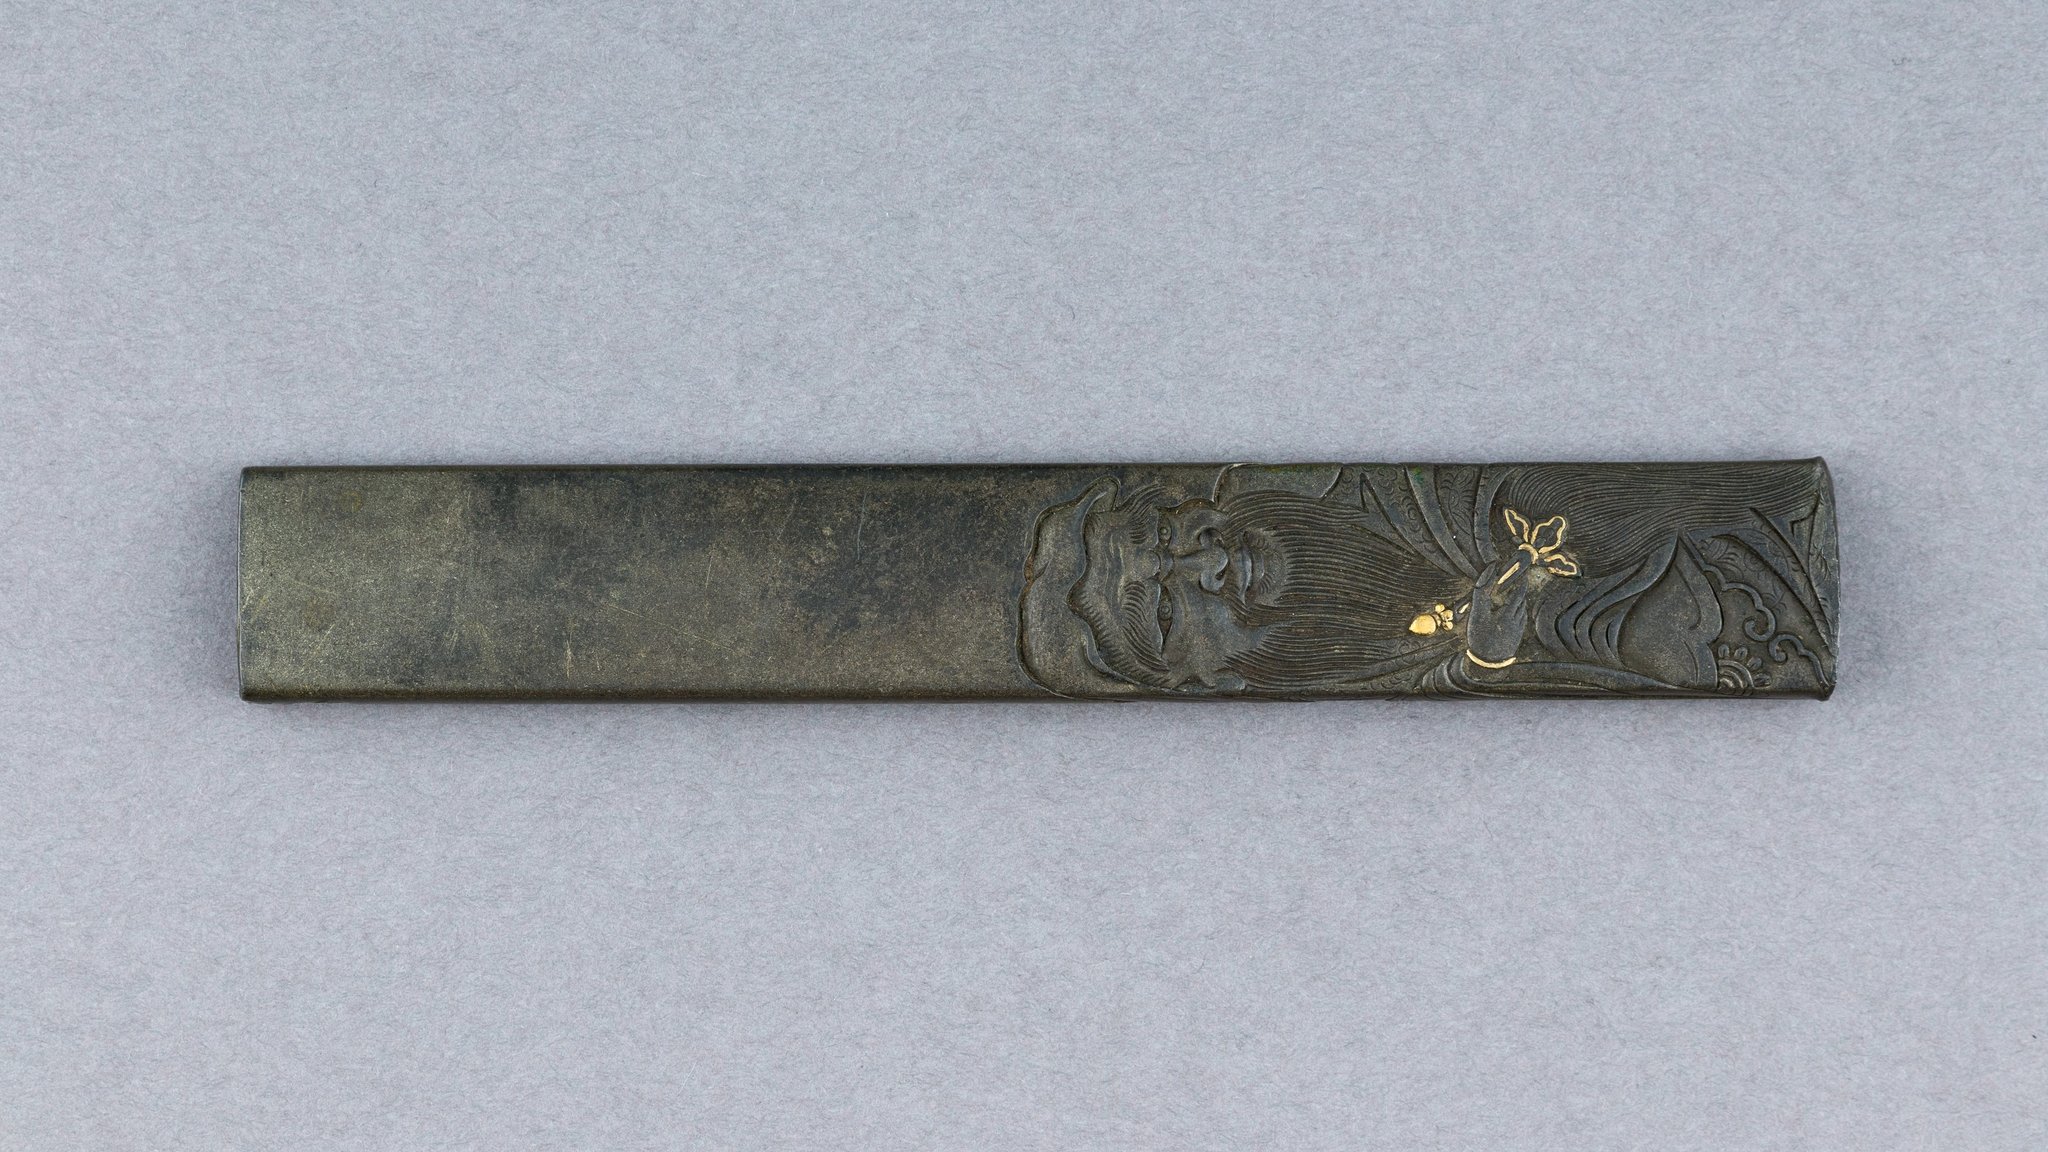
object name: knife handle kozuka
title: Knife Handle (Kozuka)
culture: japanese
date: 1615-1868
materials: silver alloy, gold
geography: japan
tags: men